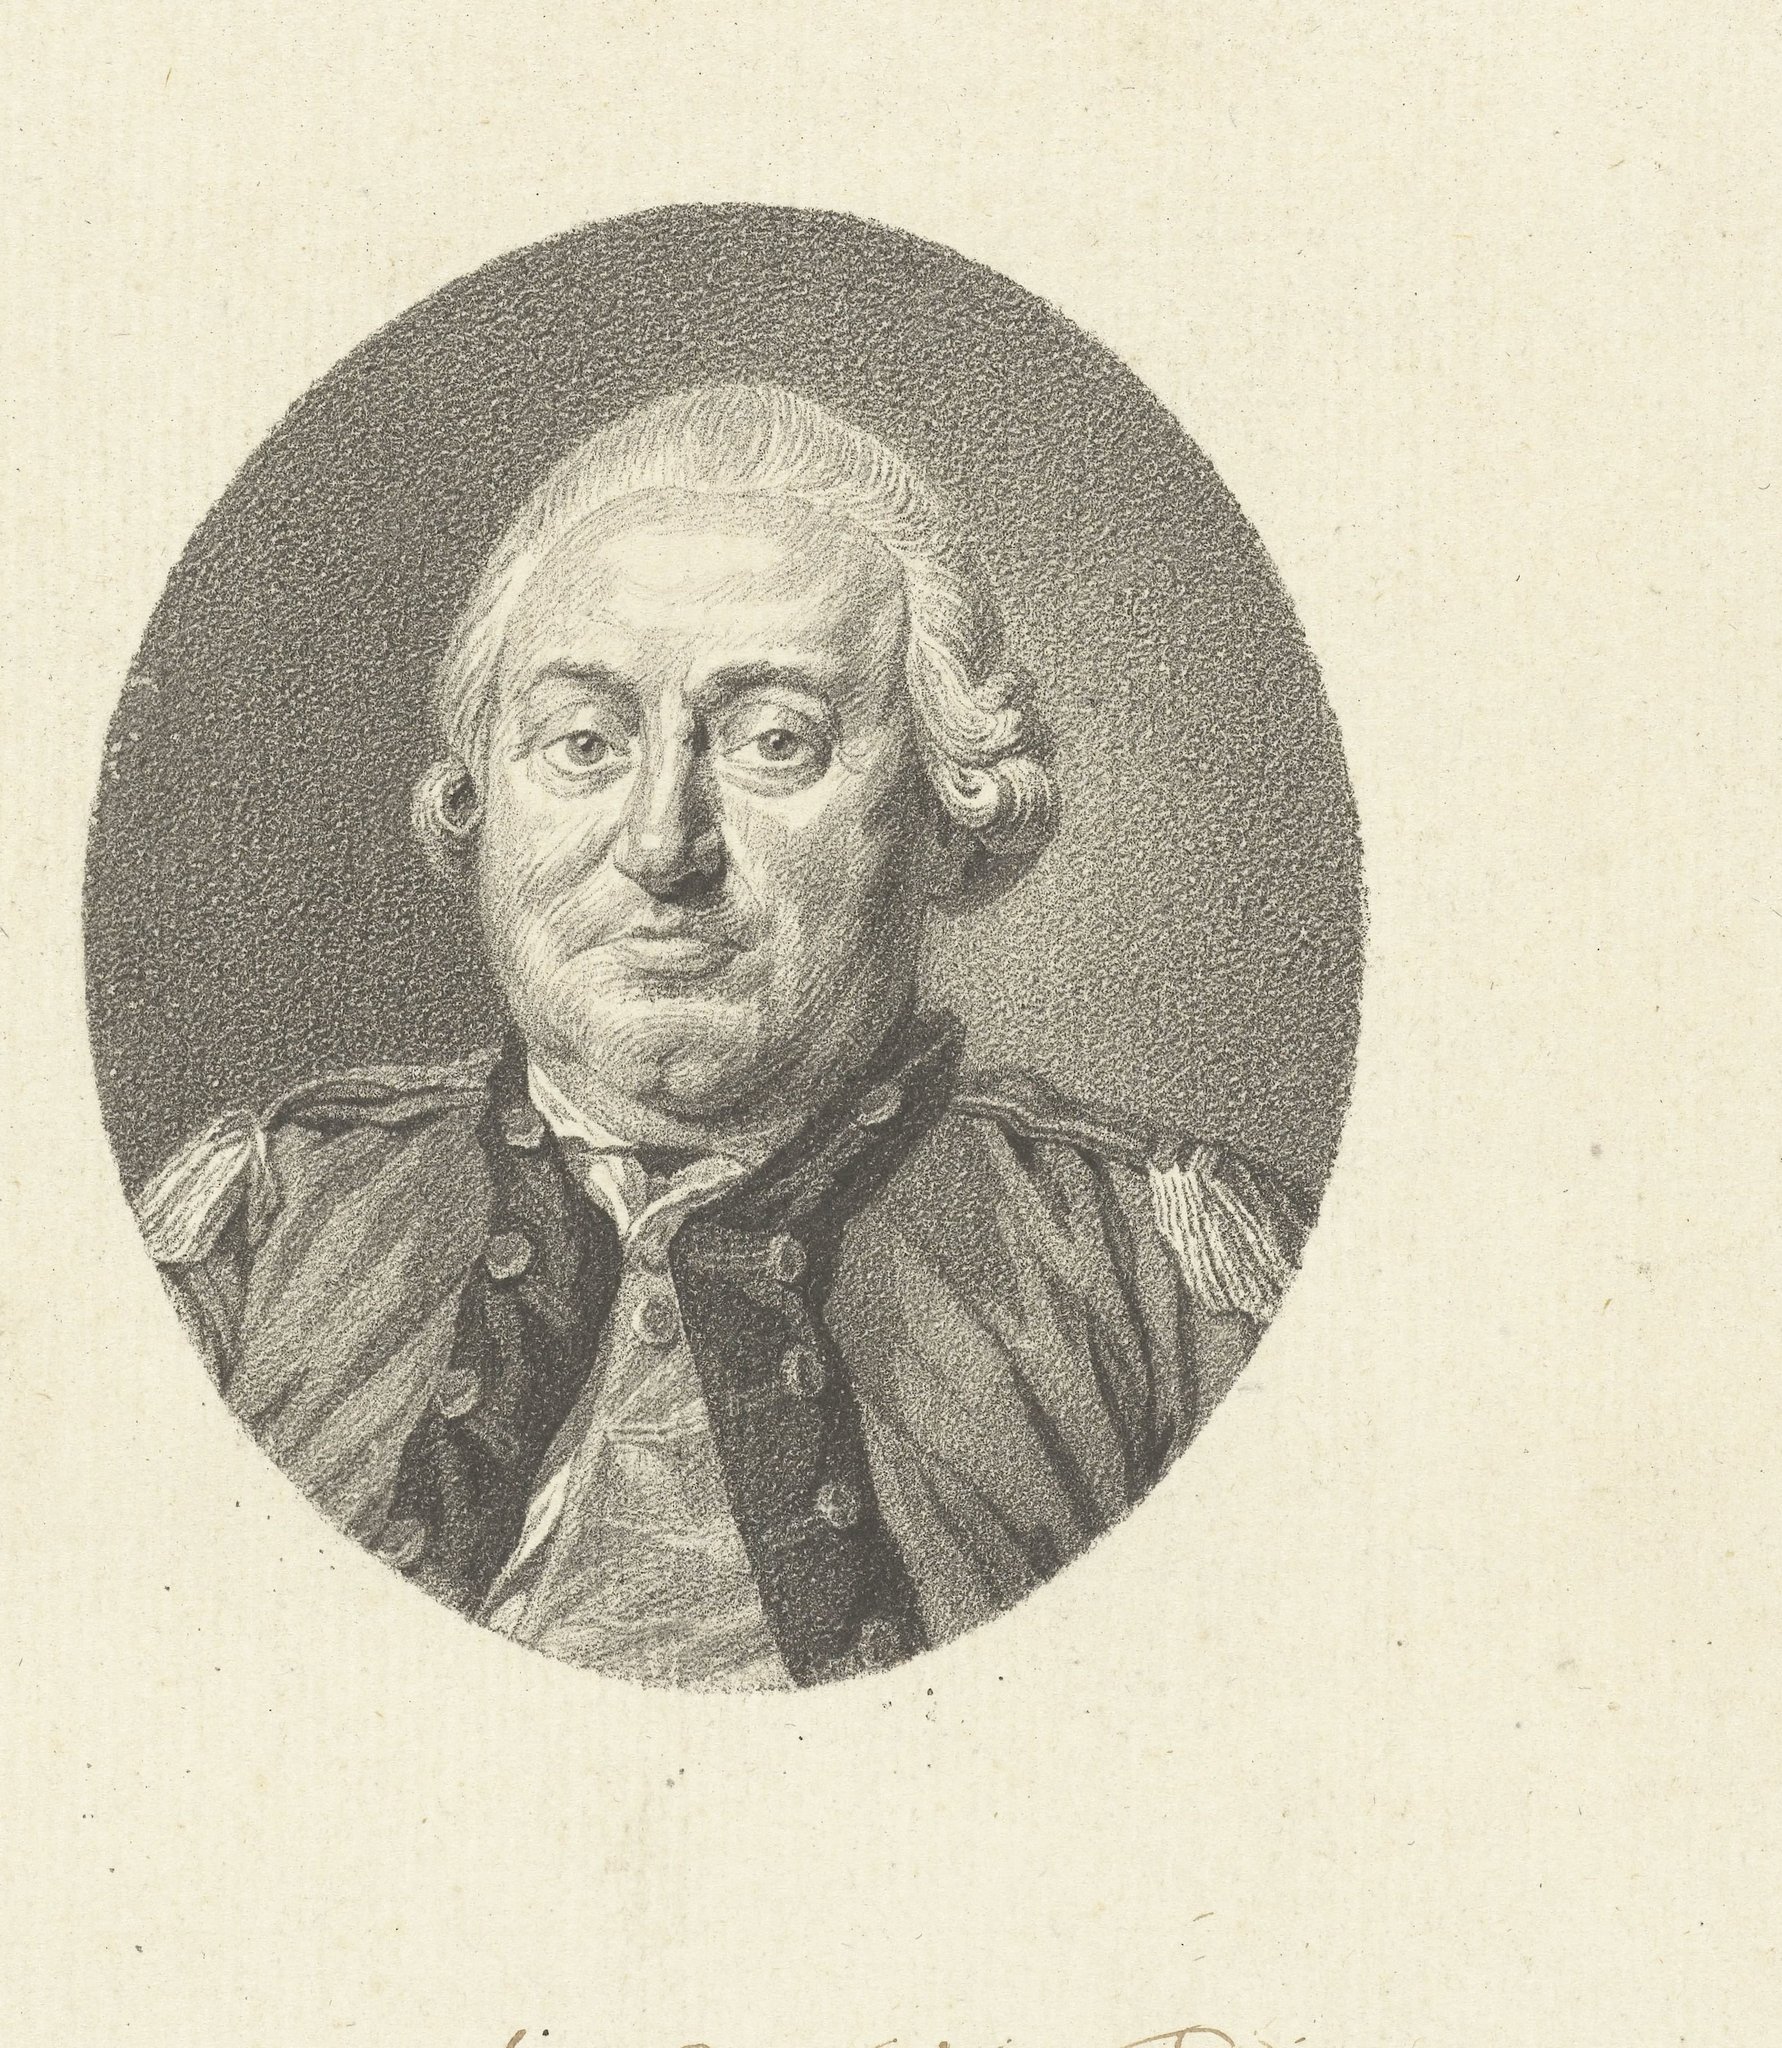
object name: drawing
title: Portret van de werktuigkundige Cornelis Redelijkheid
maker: johannes cornelis mertens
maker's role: draughtsman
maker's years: 1742-1823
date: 1752-1823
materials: chalk, paper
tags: rotterdam, cornelis redelijkheid, historical persons